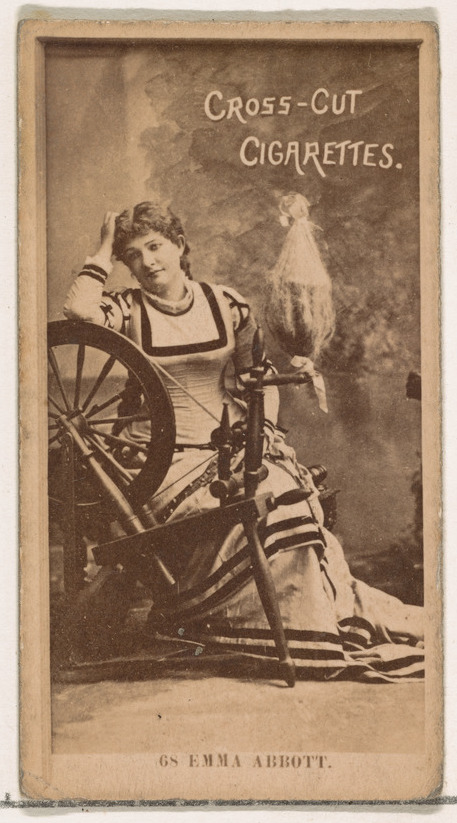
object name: print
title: Card Number 68, Emma Abbott, from the Actors and Actresses series (N145-2) issued by Duke Sons & Co. to promote Cross Cut Cigarettes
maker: w. duke, sons & co.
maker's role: publisher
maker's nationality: american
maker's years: 1870-1920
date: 1880-1889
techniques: albumen silver print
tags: portraits,women,actresses,spinning wheel